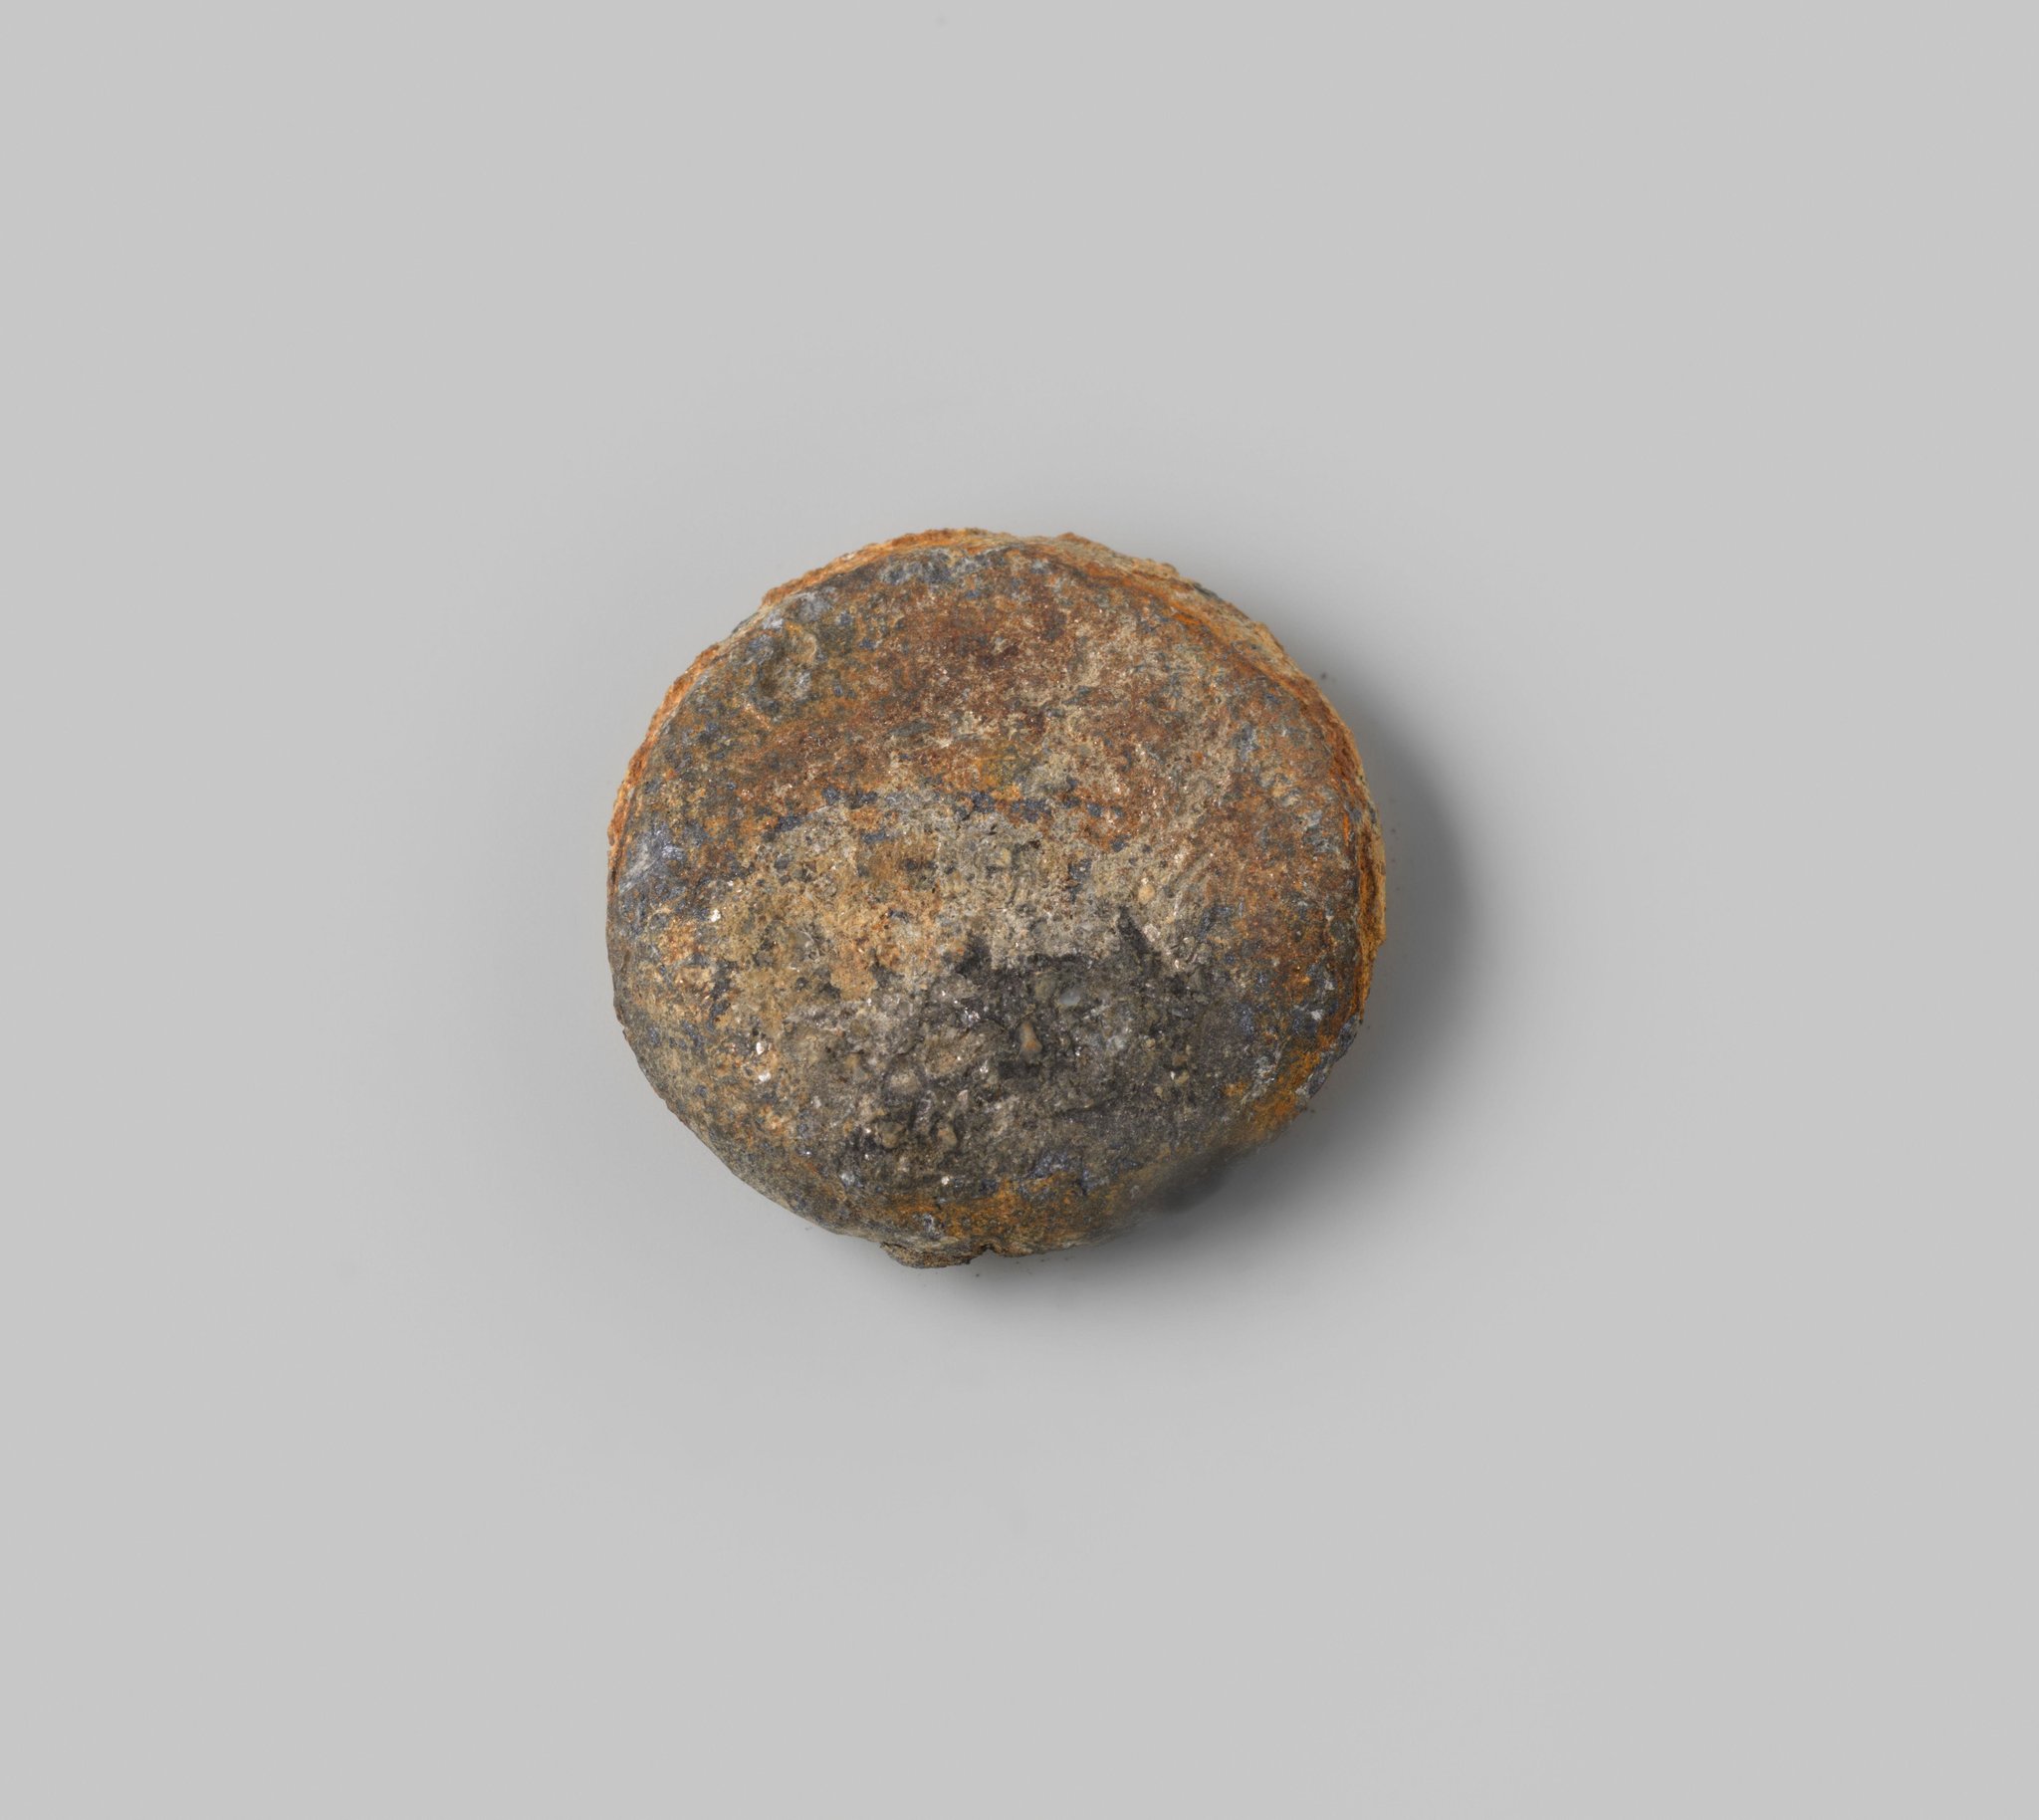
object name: weight scale component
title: Gewicht uit het wrak van de Oost-Indiëvaarder Hollandia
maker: Anonymous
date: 1700-1743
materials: lead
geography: netherlands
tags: verenigde oostindische compagnie, hollandia (schip), annet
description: Disc-shaped weight, id. NG 1979-515H, encrusted.